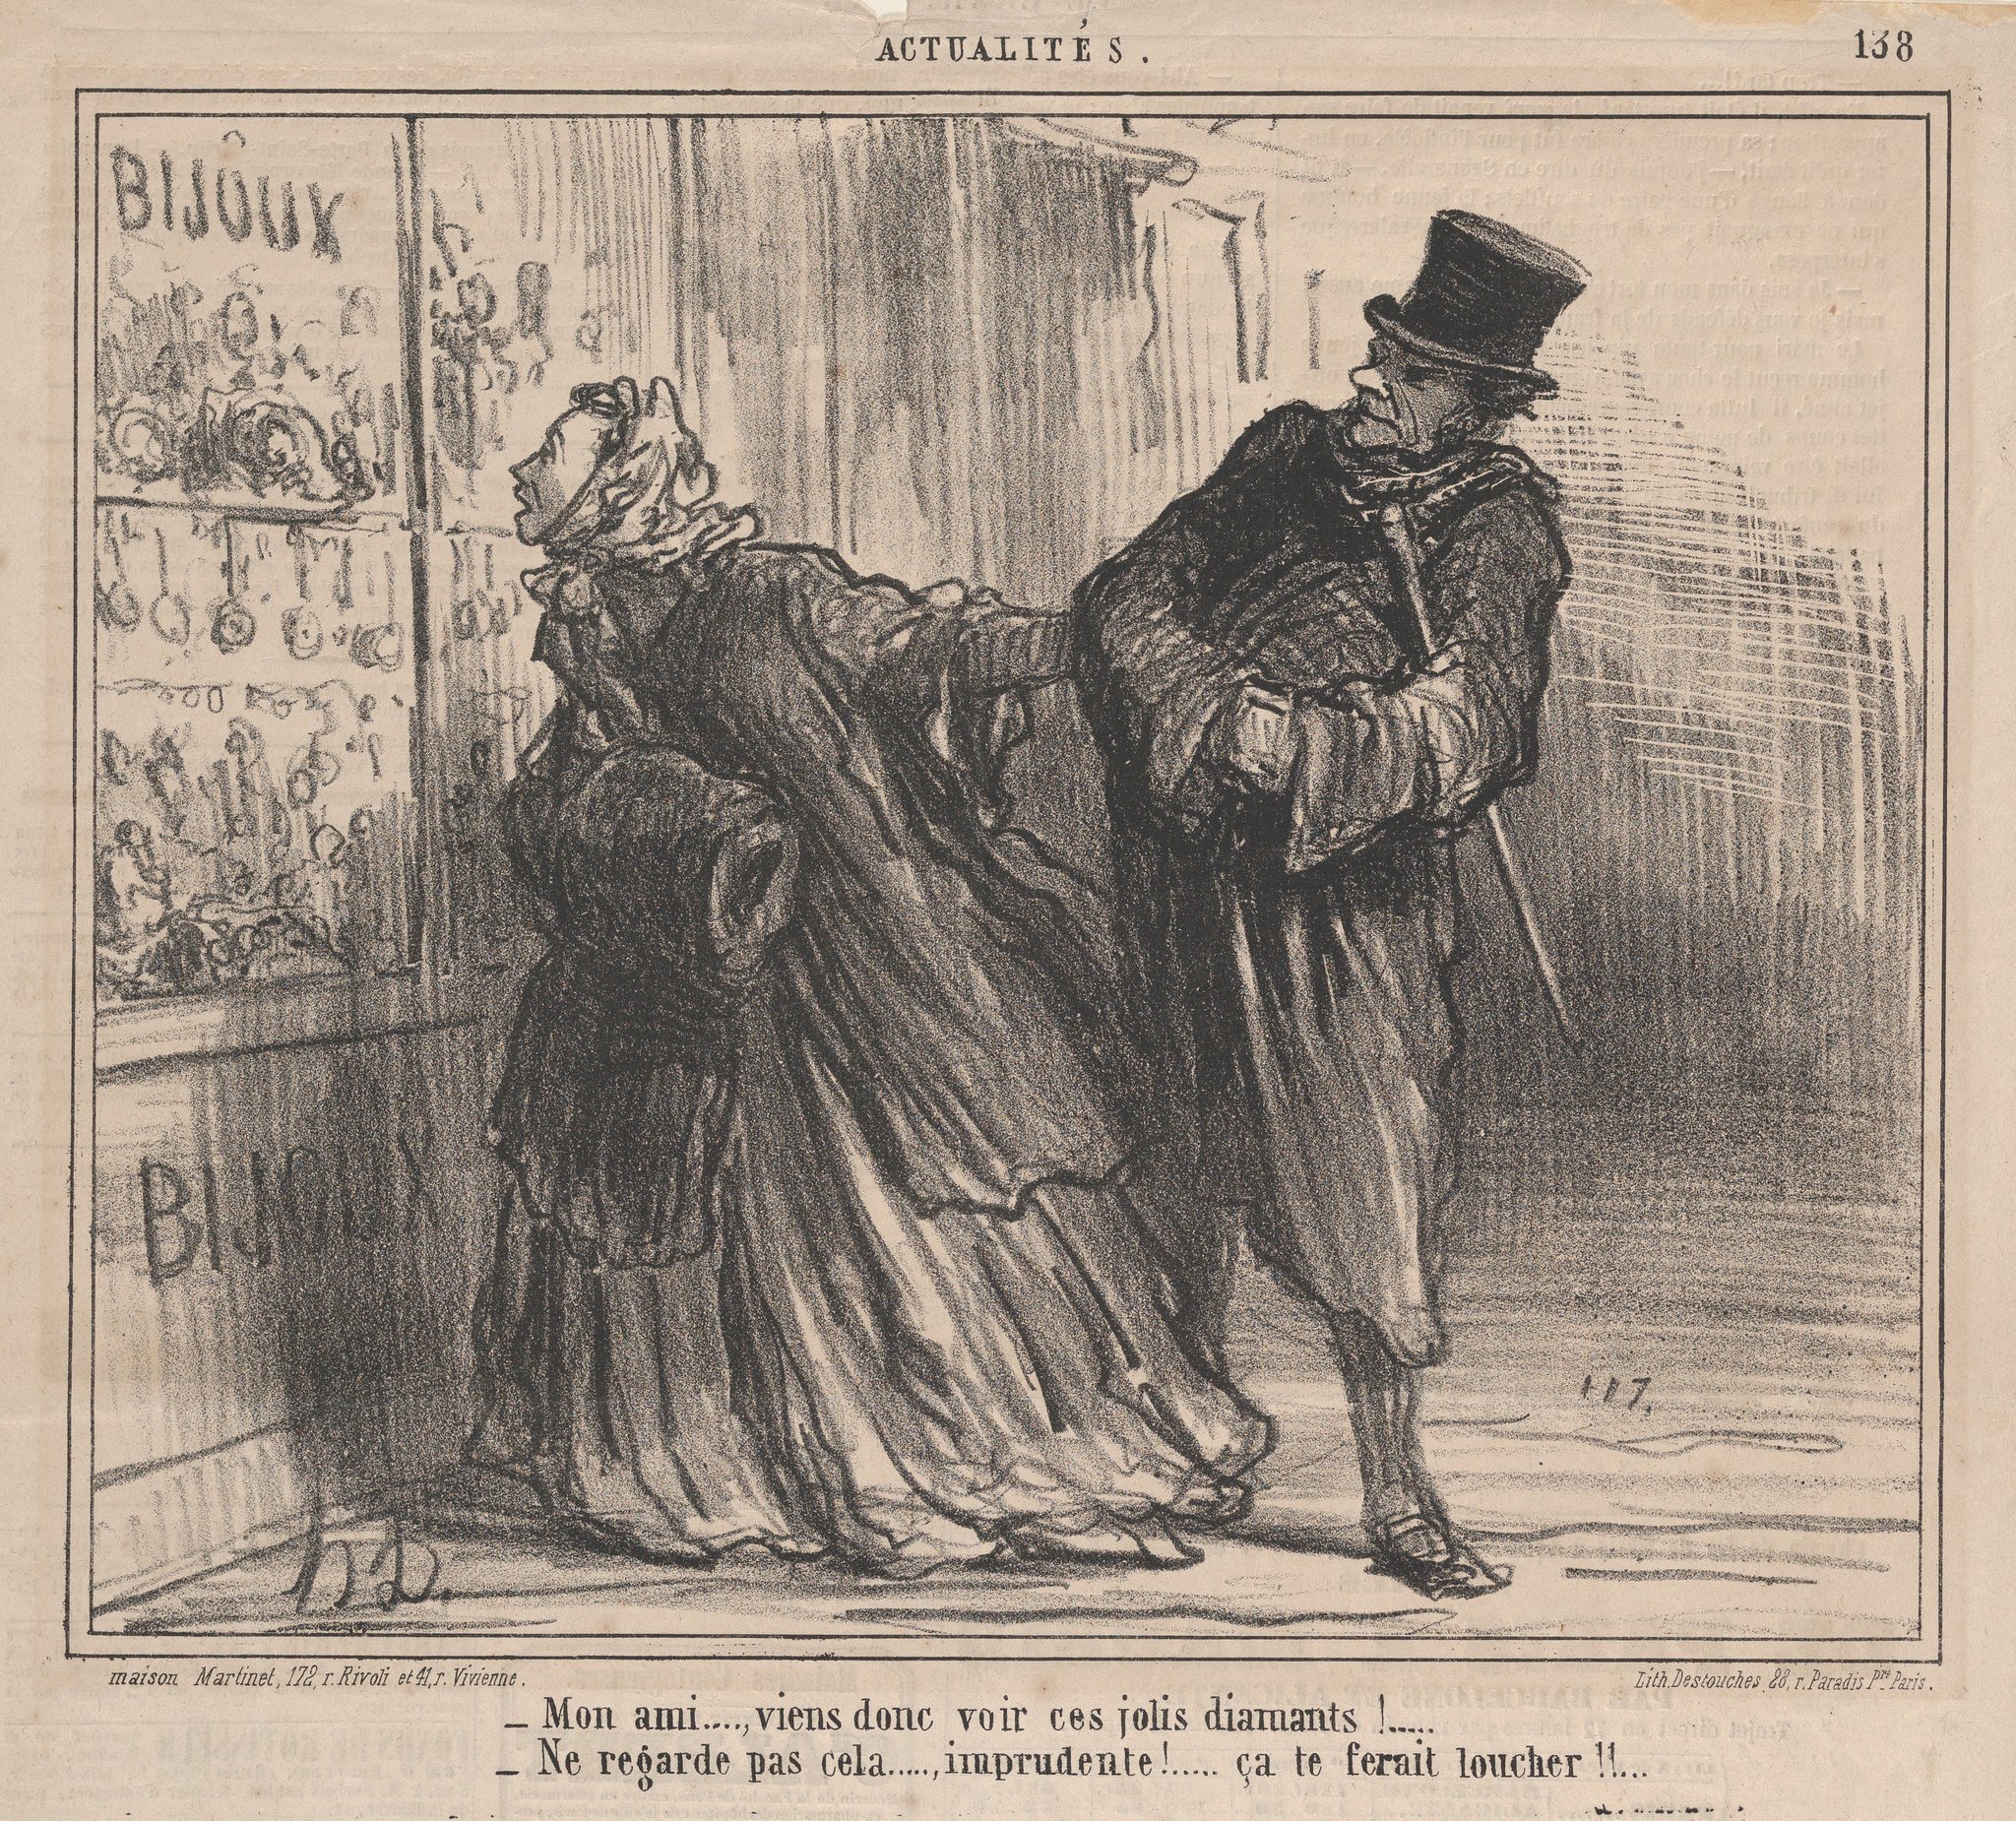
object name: print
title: My dear, come and have a look at these beautiful diamonds!, from 'News of the Day,' published in Le Charivari, January 20, 1860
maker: honoré daumier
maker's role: artist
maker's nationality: french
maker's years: 1808-1879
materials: paper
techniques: lithograph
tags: men,women